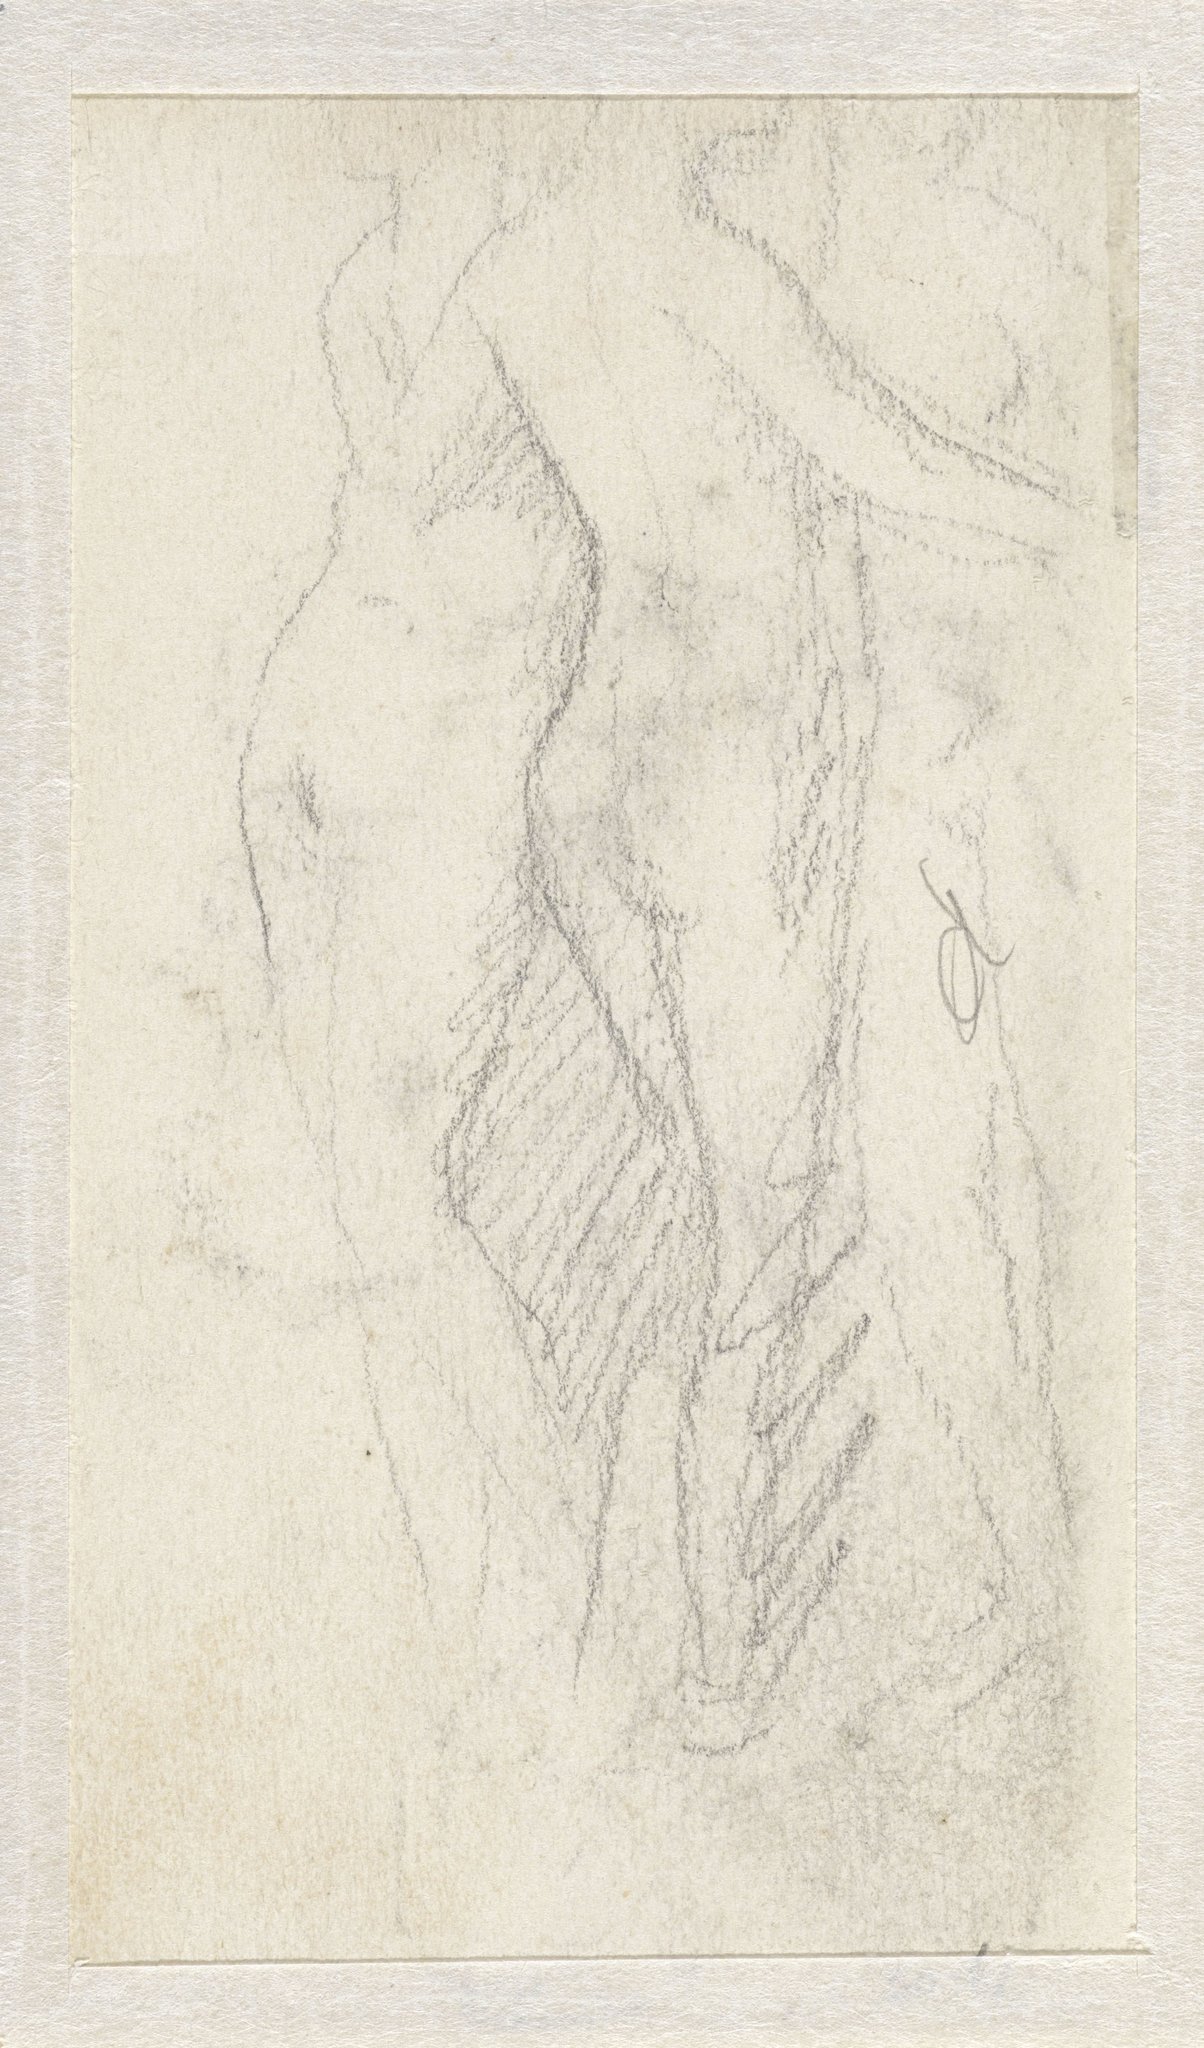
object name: drawing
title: Landschap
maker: jacob maris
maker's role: draughtsman, painter, print maker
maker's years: 1837-1899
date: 1847-1899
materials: paper, pencil